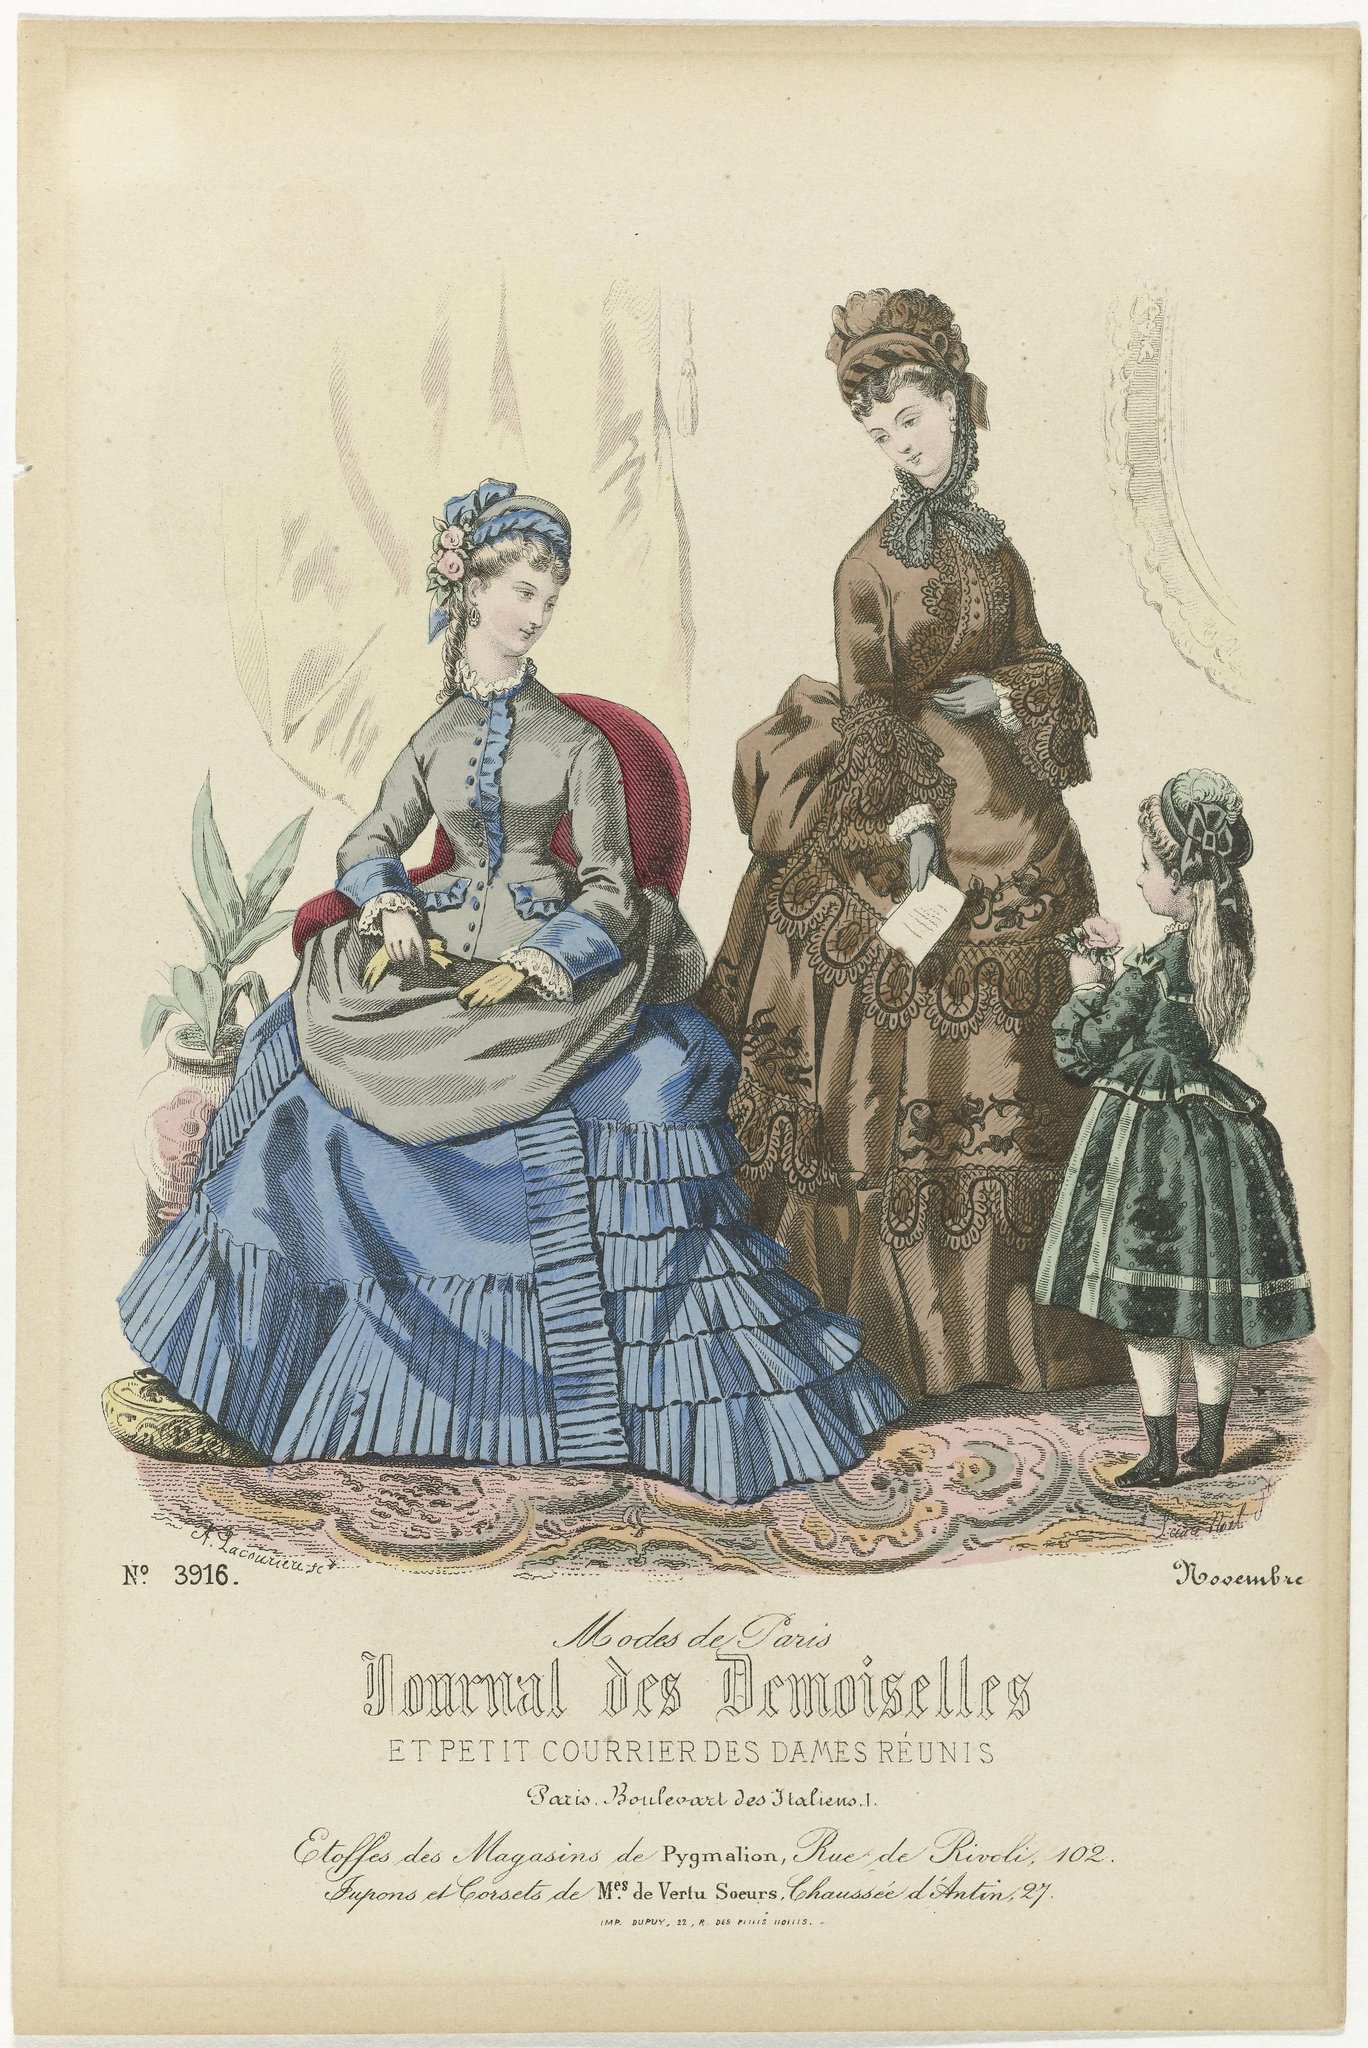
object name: fashion print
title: Journal des Demoiselles et Petit Courrier des Dames Réunis, Novembre 1873, No. 3916 : Etoffes des Magasins (...)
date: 1873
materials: paper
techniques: engraving, hand coloring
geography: paris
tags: clothing for the upper part of the body (+ women's clothes), ear-rings (+ women's clothes), cut flowers; nosegay, bunch of flowers, head-gear (+ girls' clothes), boots (+ girls' clothes), head-gear (+ women's clothes), fashion plates, skirt (+ women's clothes), gloves, mittens, etc. (+ women's clothes), letter, envelope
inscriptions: address: ‘Paris, Boulevart des Italiens,1.’, title: ‘Modes de Paris / Journal des Demoiselles / et Petit Courrier des Dames Réunis’, caption: ‘Etoffes des Magasins de Pygmalion, Rue de Ricoli, 102. Jupons et Corsets de Mes de Vertu Soeurs, Chaussée d'Antin, 27.’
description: Twee vrouwen en meisje in interieur, gekleed in japonnen met queue. Onder de voorstelling enkele regels reclametekst voor verschillende producten. Prent uit het modetijdschrift Journal des Demoiselles (et Petit Courrier des Dames Réunis) (1833-1922).